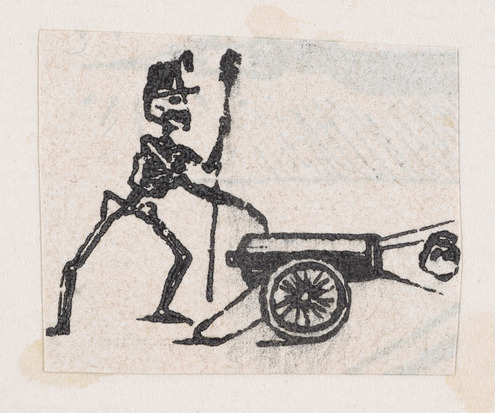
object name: print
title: Skeleton firing a canon, from a broadside entitled 'De este famoso hipodromo en la pista, no faltara ni un solo periodista', published by Antonio Vanegas Arroyo.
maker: josé guadalupe posada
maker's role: artist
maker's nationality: mexican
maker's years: 1852-1913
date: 1889-1895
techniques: lithography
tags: cannons,skeletons